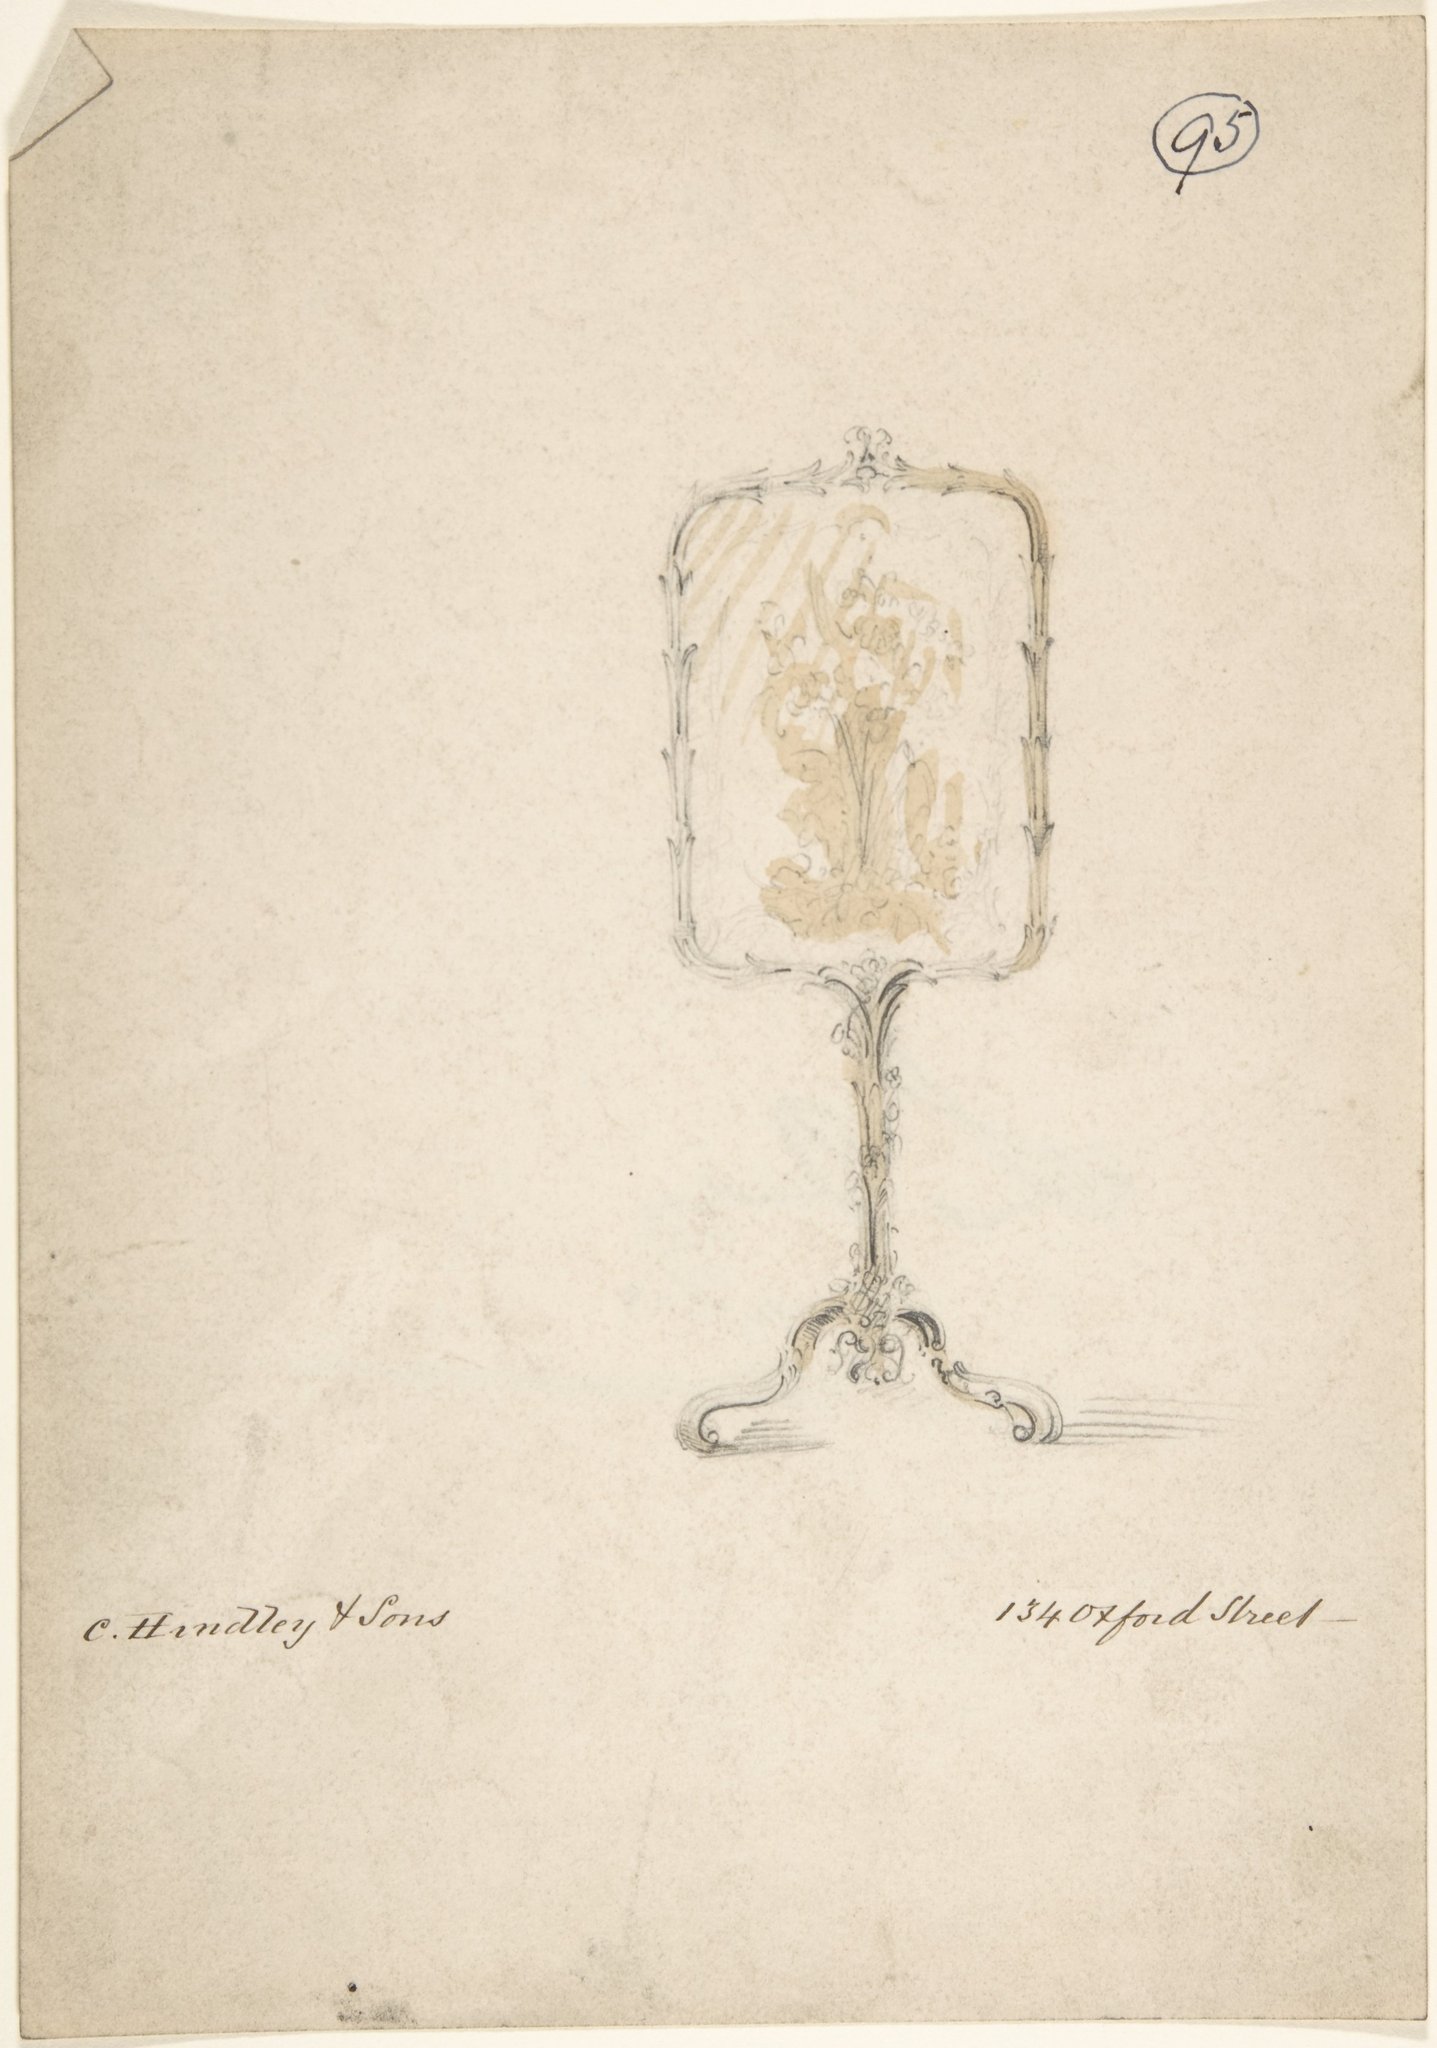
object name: drawing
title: Design for Screen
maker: charles hindley and sons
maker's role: artist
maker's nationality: british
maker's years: 1841-1917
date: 1841-1884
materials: graphite, ink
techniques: brush, pen, wash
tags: screens